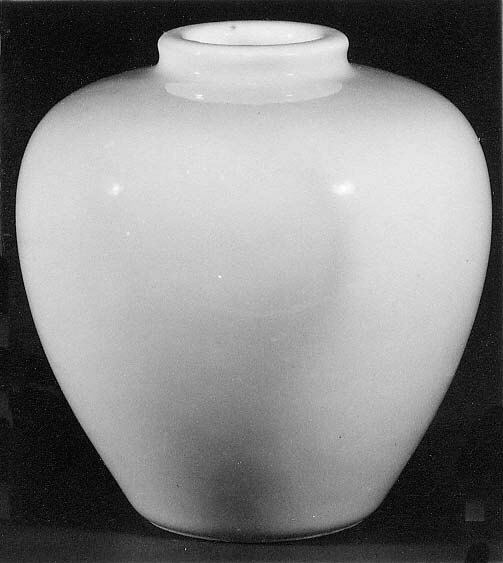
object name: jar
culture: chinese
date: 1701-1800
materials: glaze, porcelain